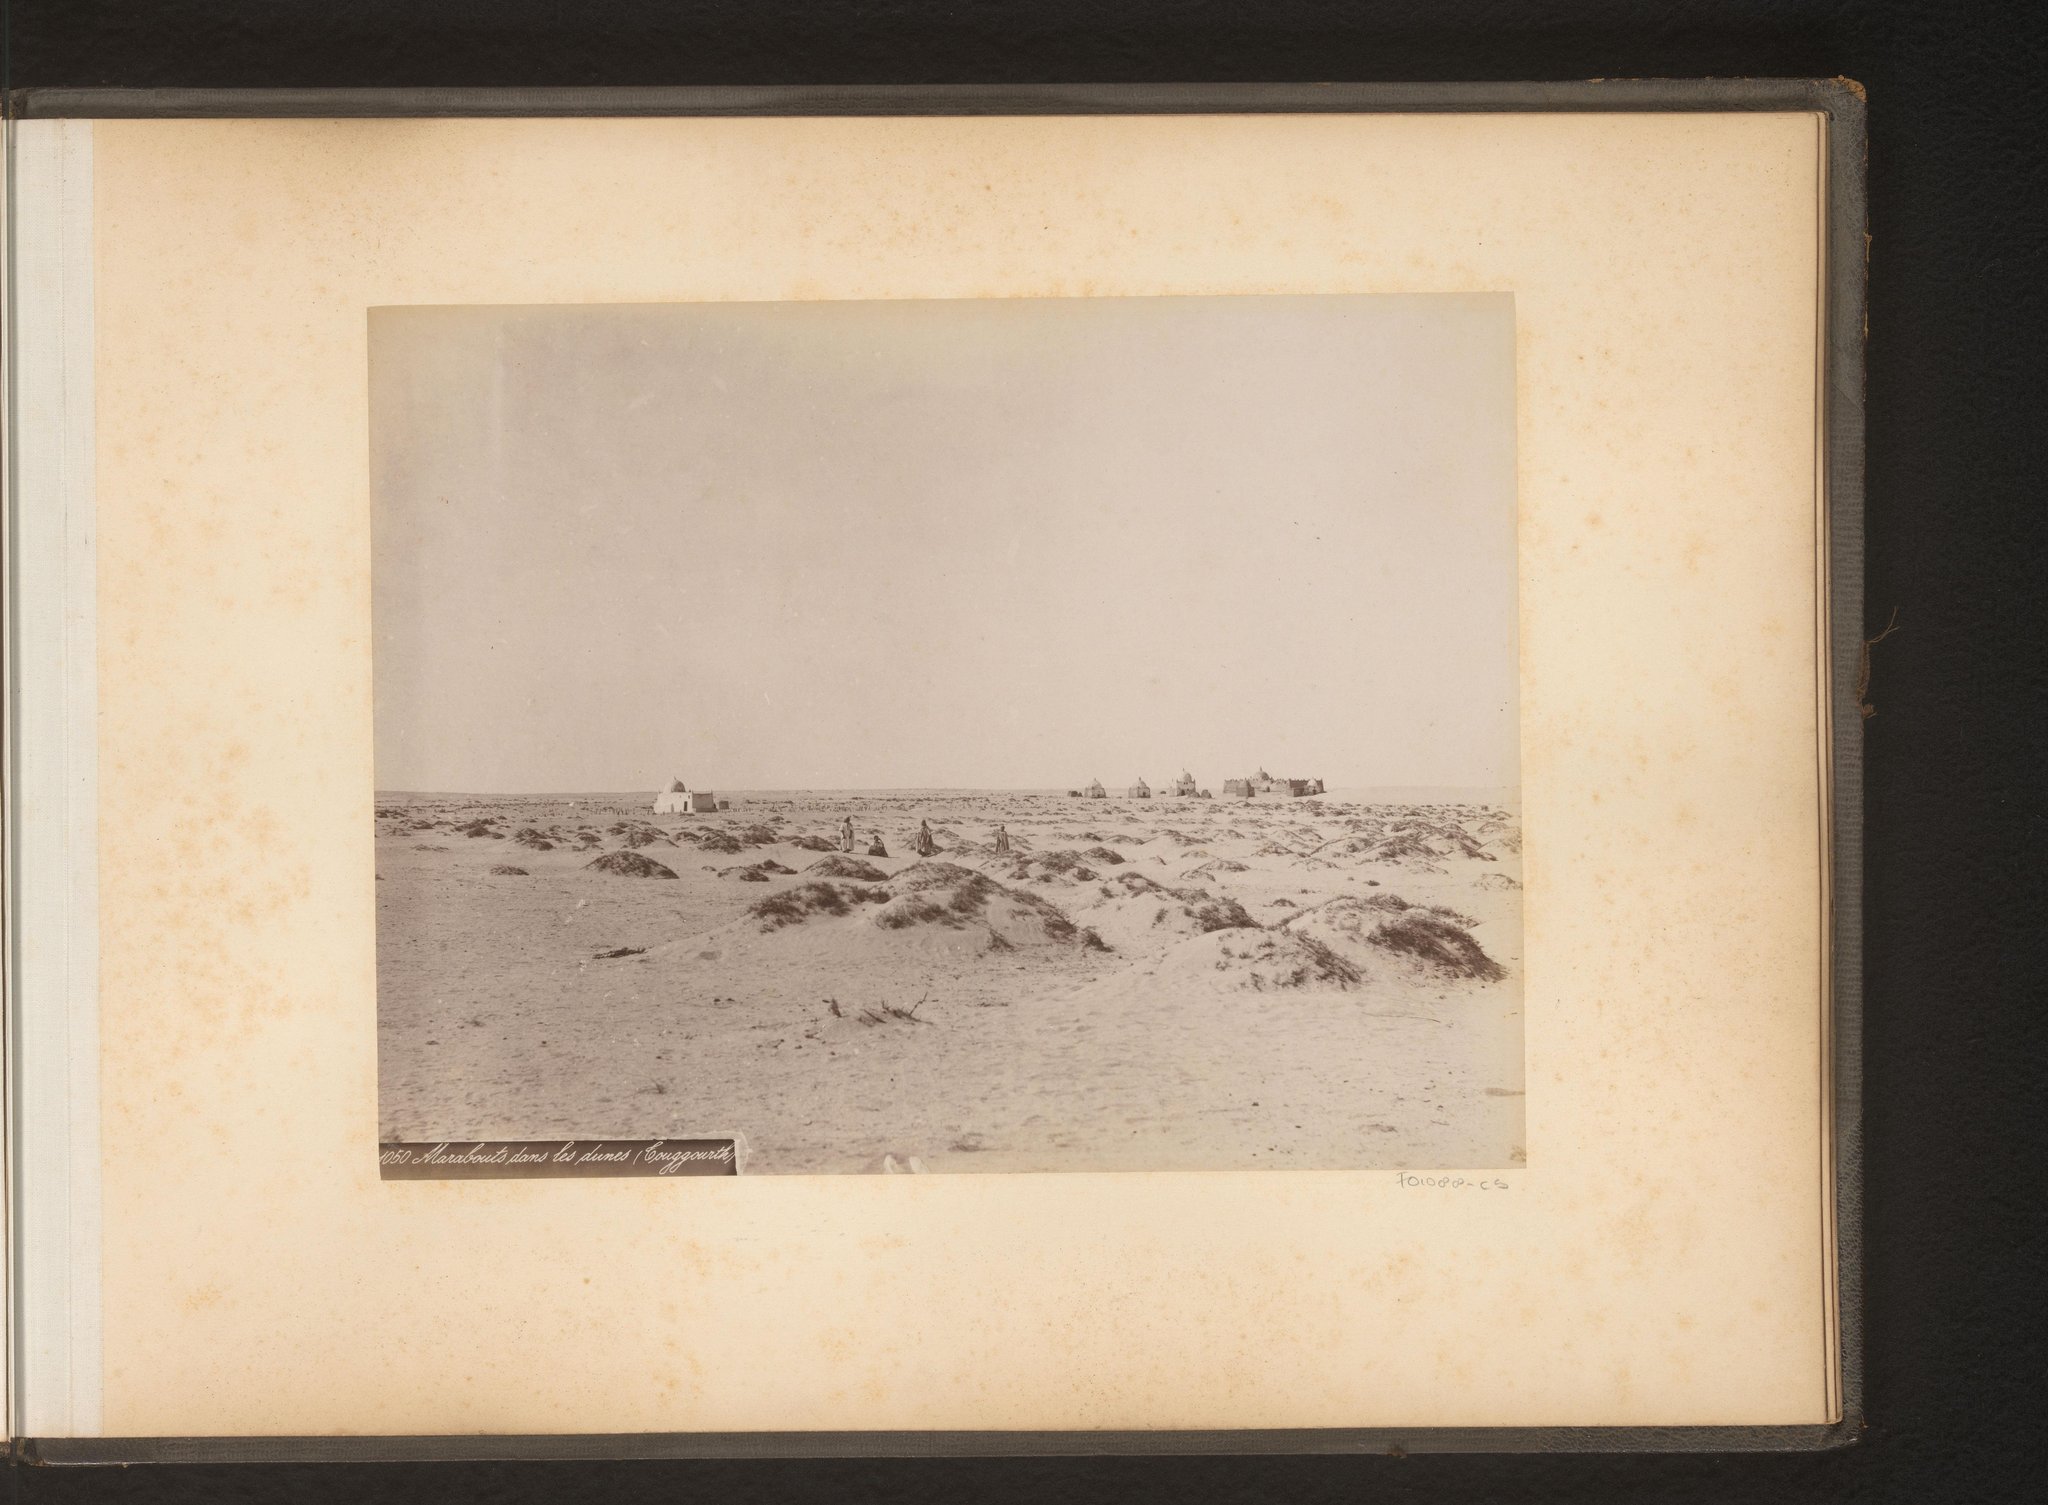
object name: album leaf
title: Maraboets in een woestijn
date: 1880-1900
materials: photographic support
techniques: albumen print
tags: historical persons, desert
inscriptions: check stamp: ‘J. Kuhn Editeur/ 220 Rue de Rivoli Paris’, number: ‘1050’